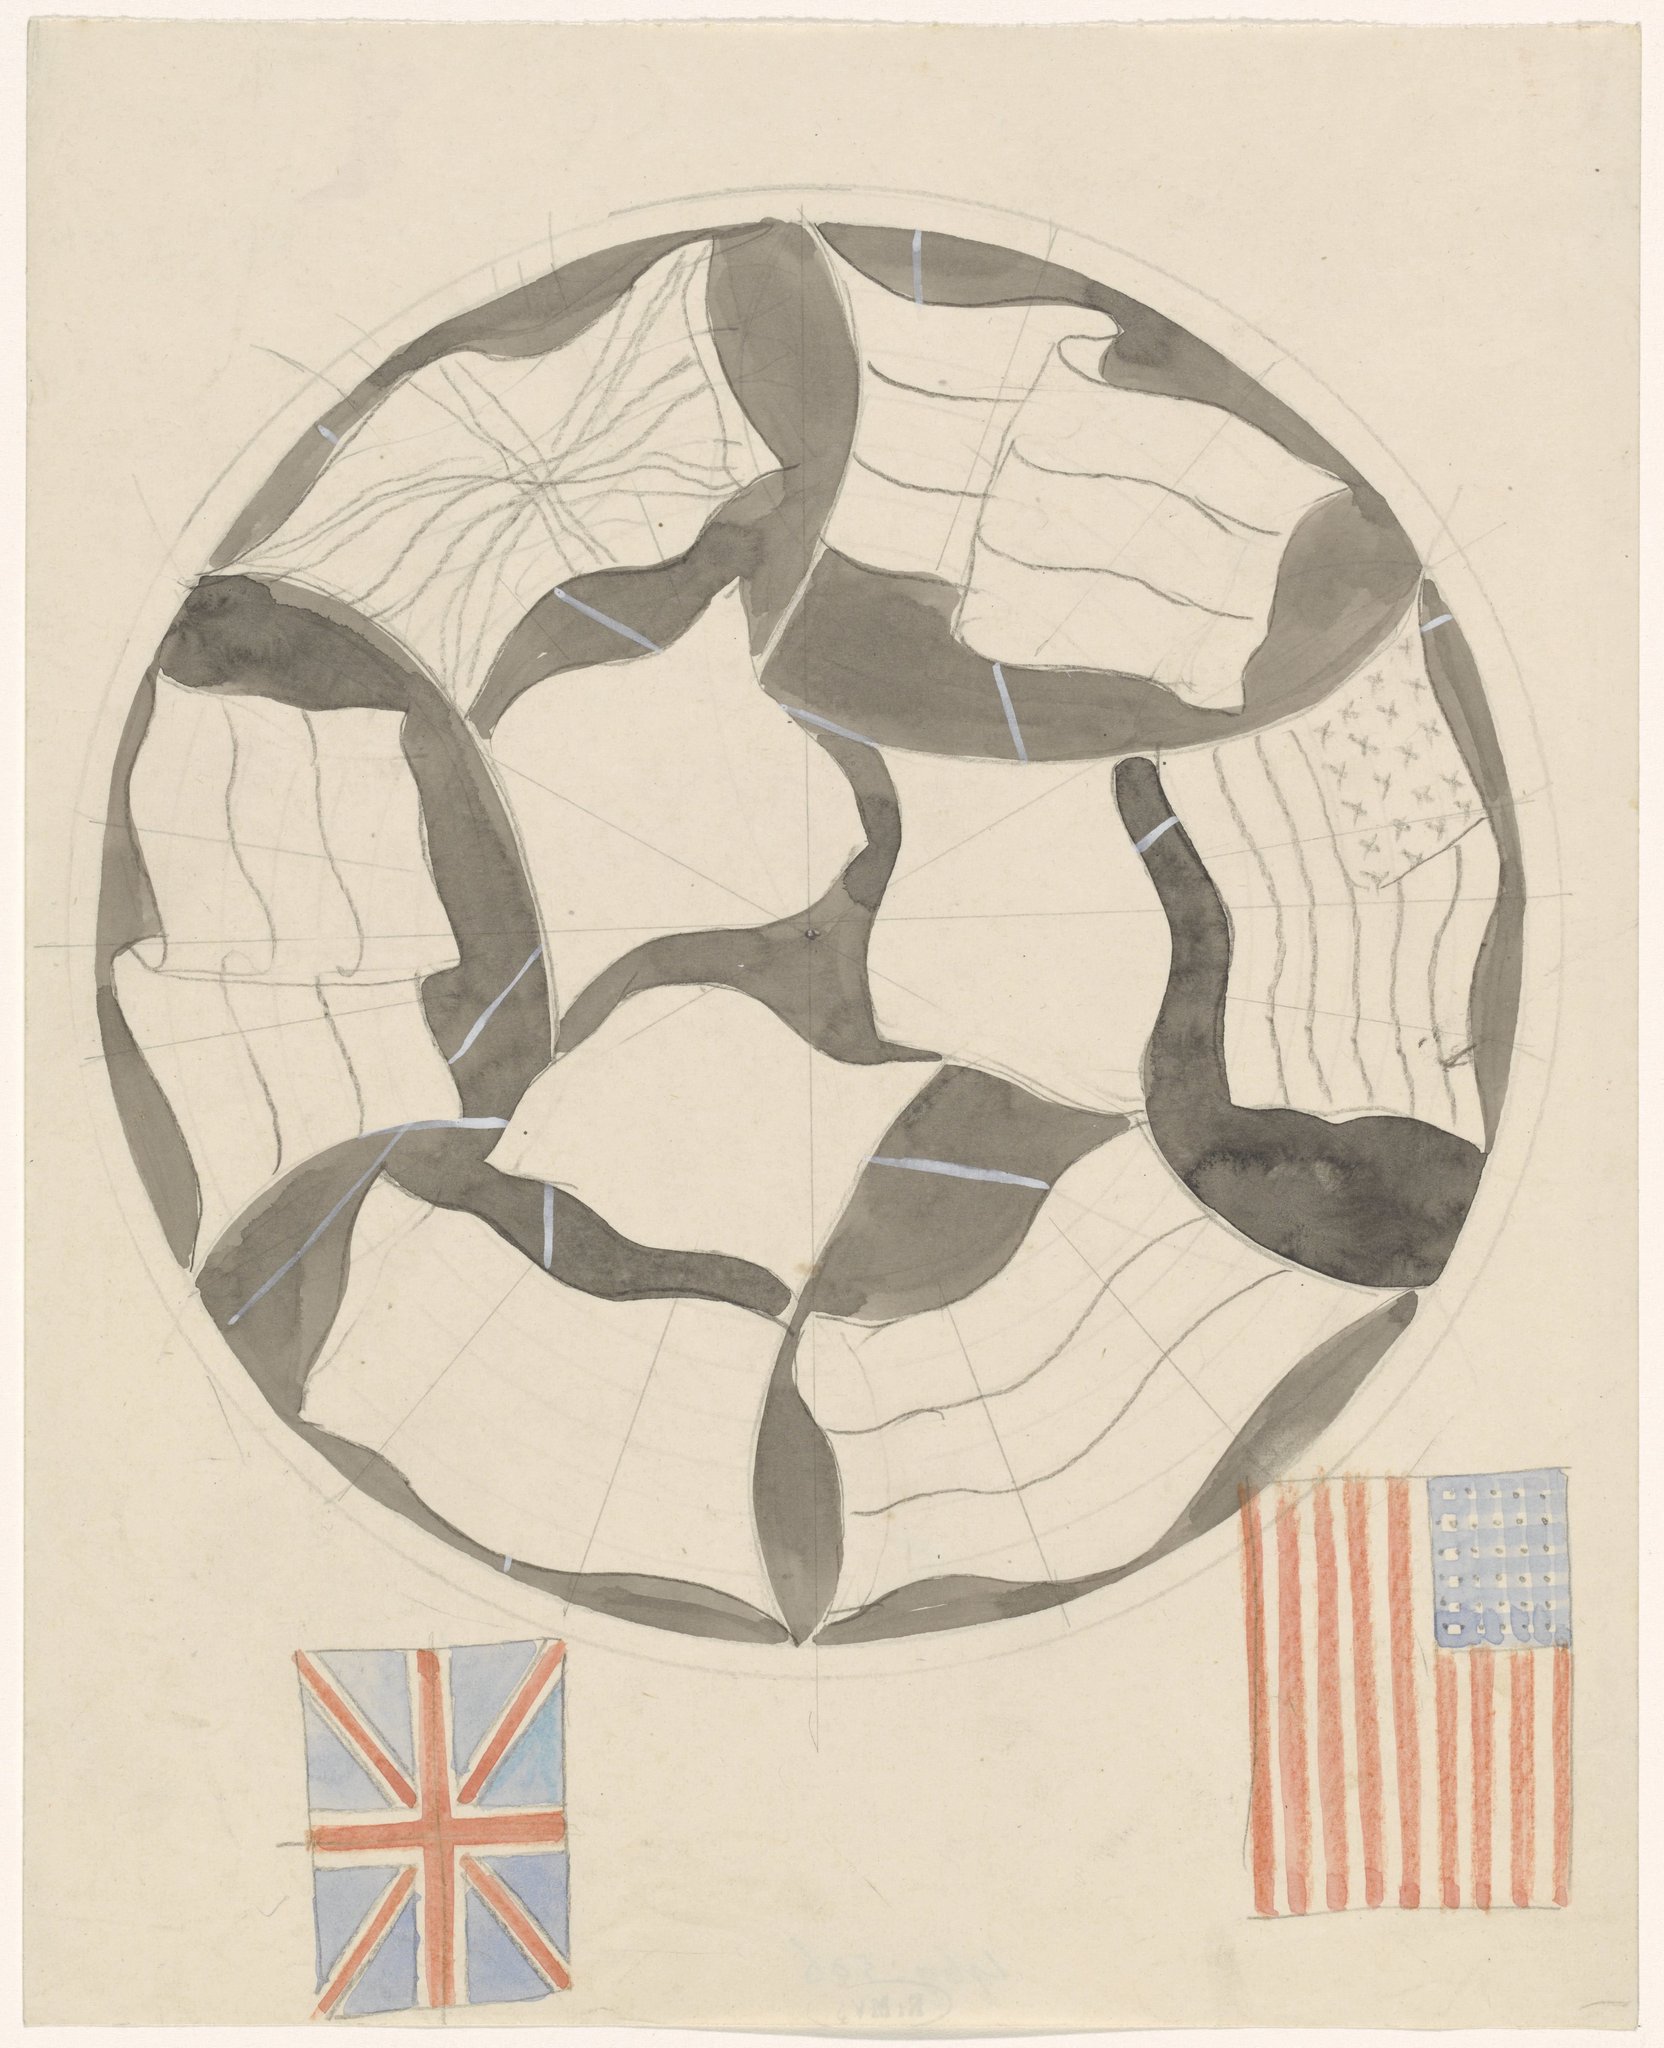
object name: design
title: Ontwerp voor een bord met vlaggen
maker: carel adolph lion cachet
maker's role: draughtsman, print maker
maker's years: 1864-1945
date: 1874-1945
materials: paper, pencil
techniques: brush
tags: work of applied art (+ ceramics ~ arts), (other) ornaments derived from objects, dish, plate, saucer, flag, colours (as symbol of the state, etc.)